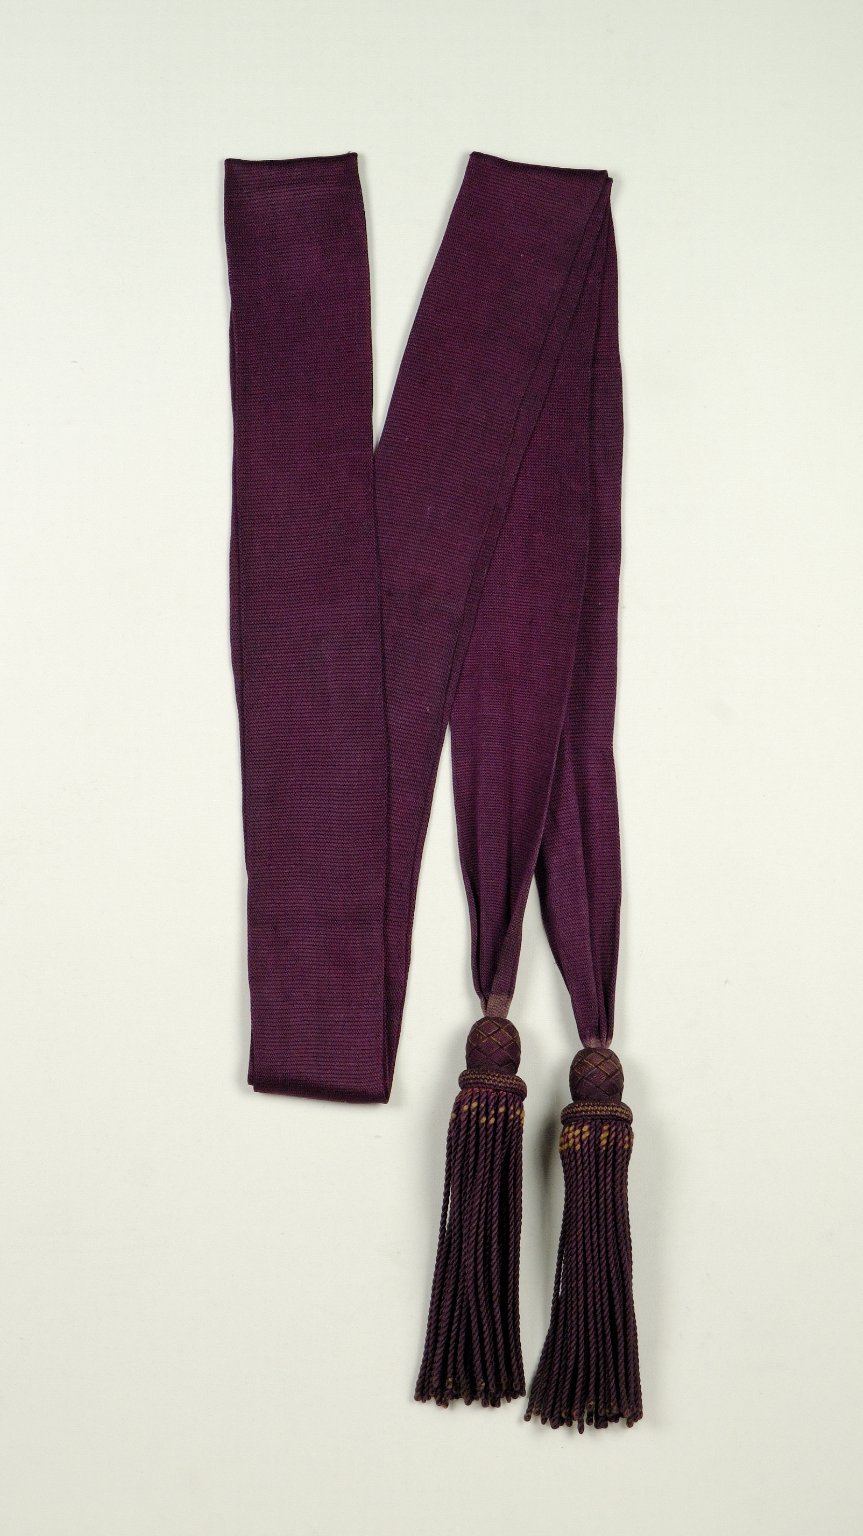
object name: military sash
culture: american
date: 1890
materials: silk